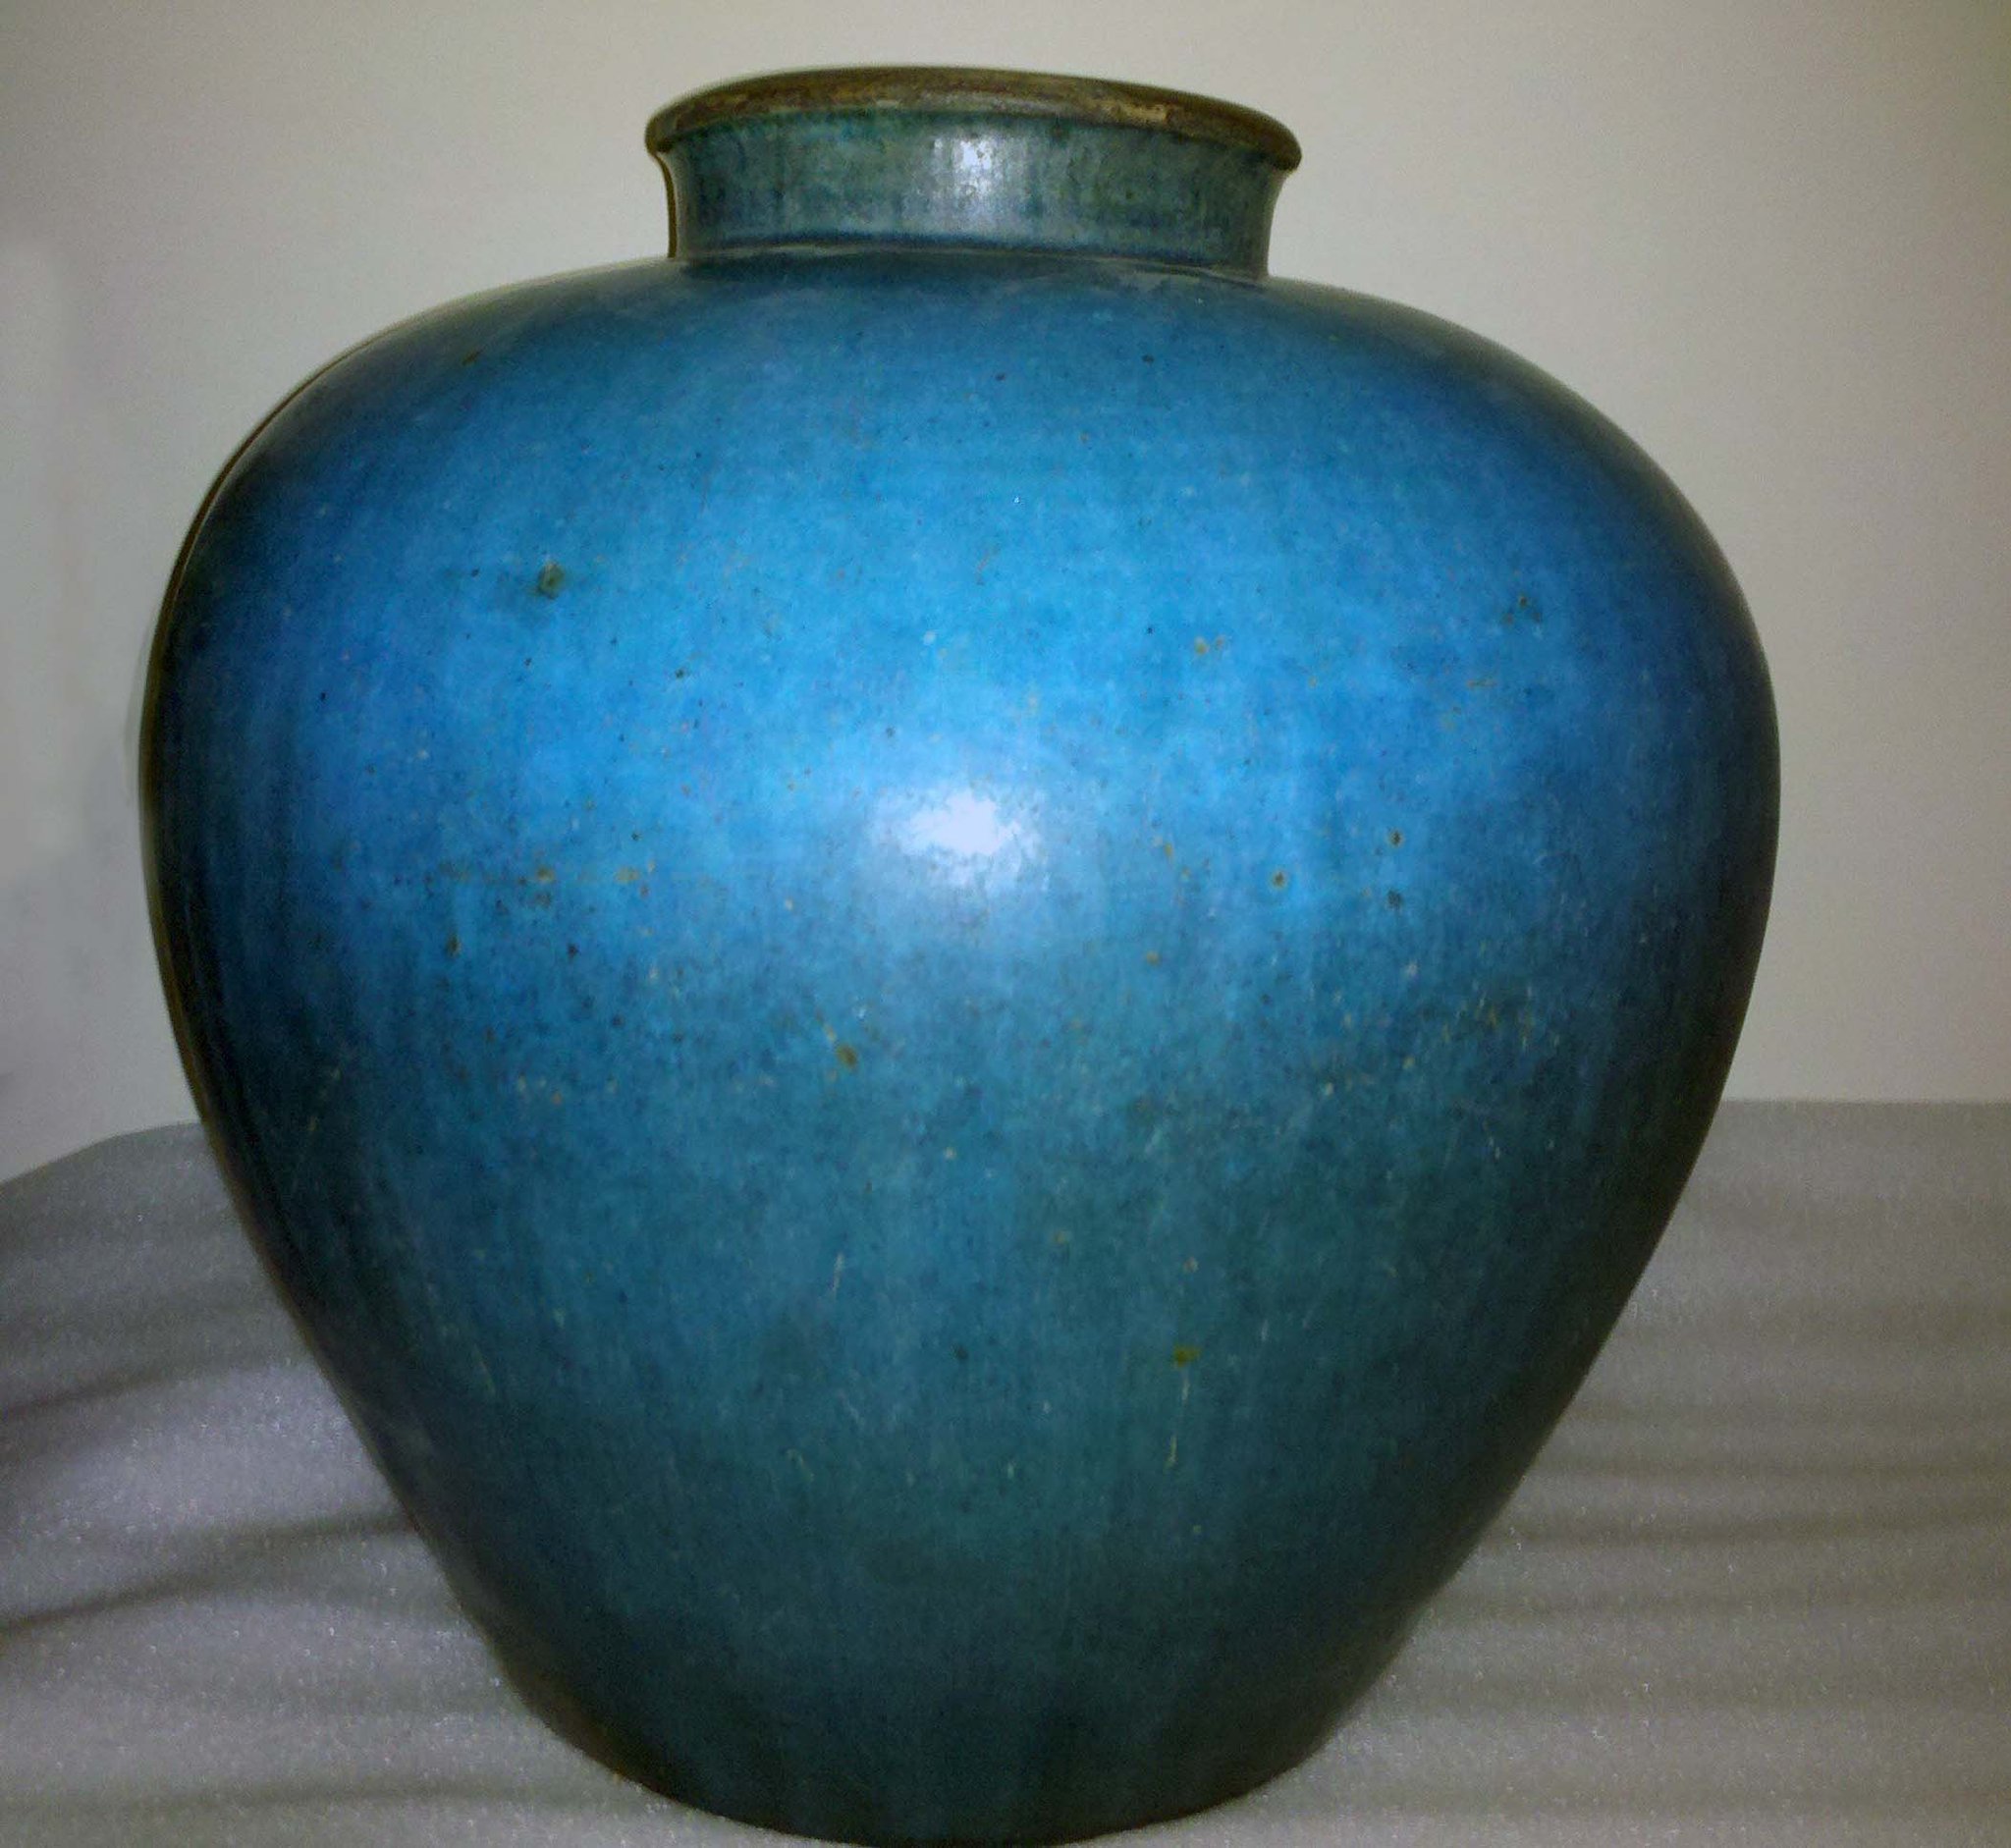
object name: jar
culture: chinese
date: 1271-1368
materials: glaze, stoneware